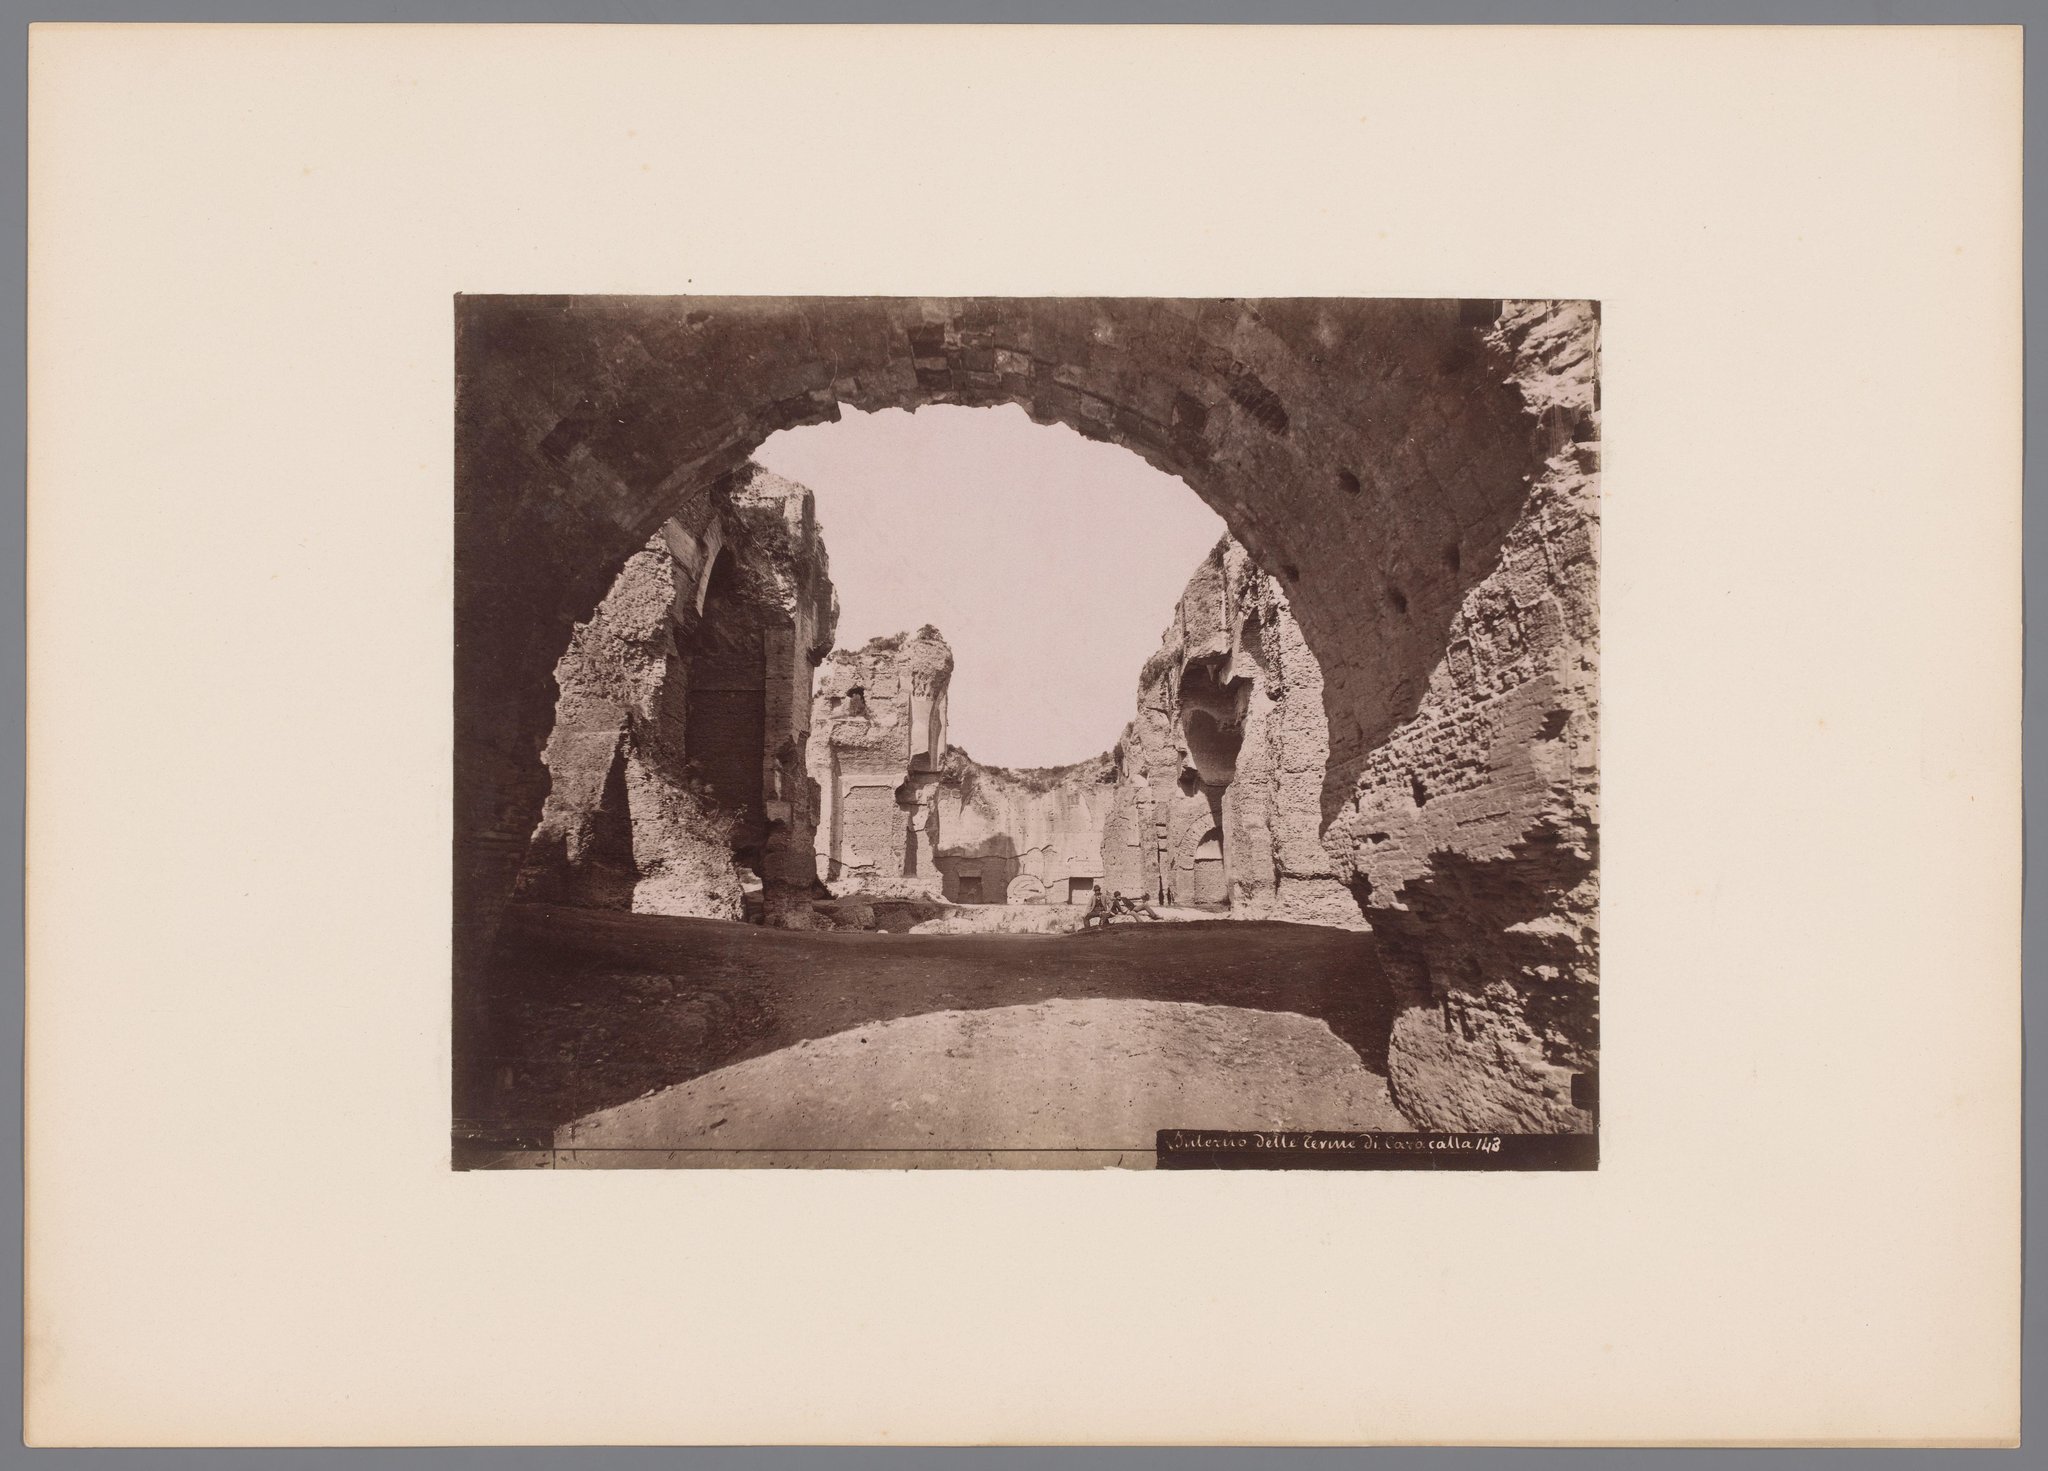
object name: photograph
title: Thermen van Caracalla te Rome, Italië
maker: Anonymous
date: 1851-1900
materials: cardboard, paper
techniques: albumen print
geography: rome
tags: ruin of a building ~ architecture, watering-place, spa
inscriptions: number: ‘47’, number: ‘143’